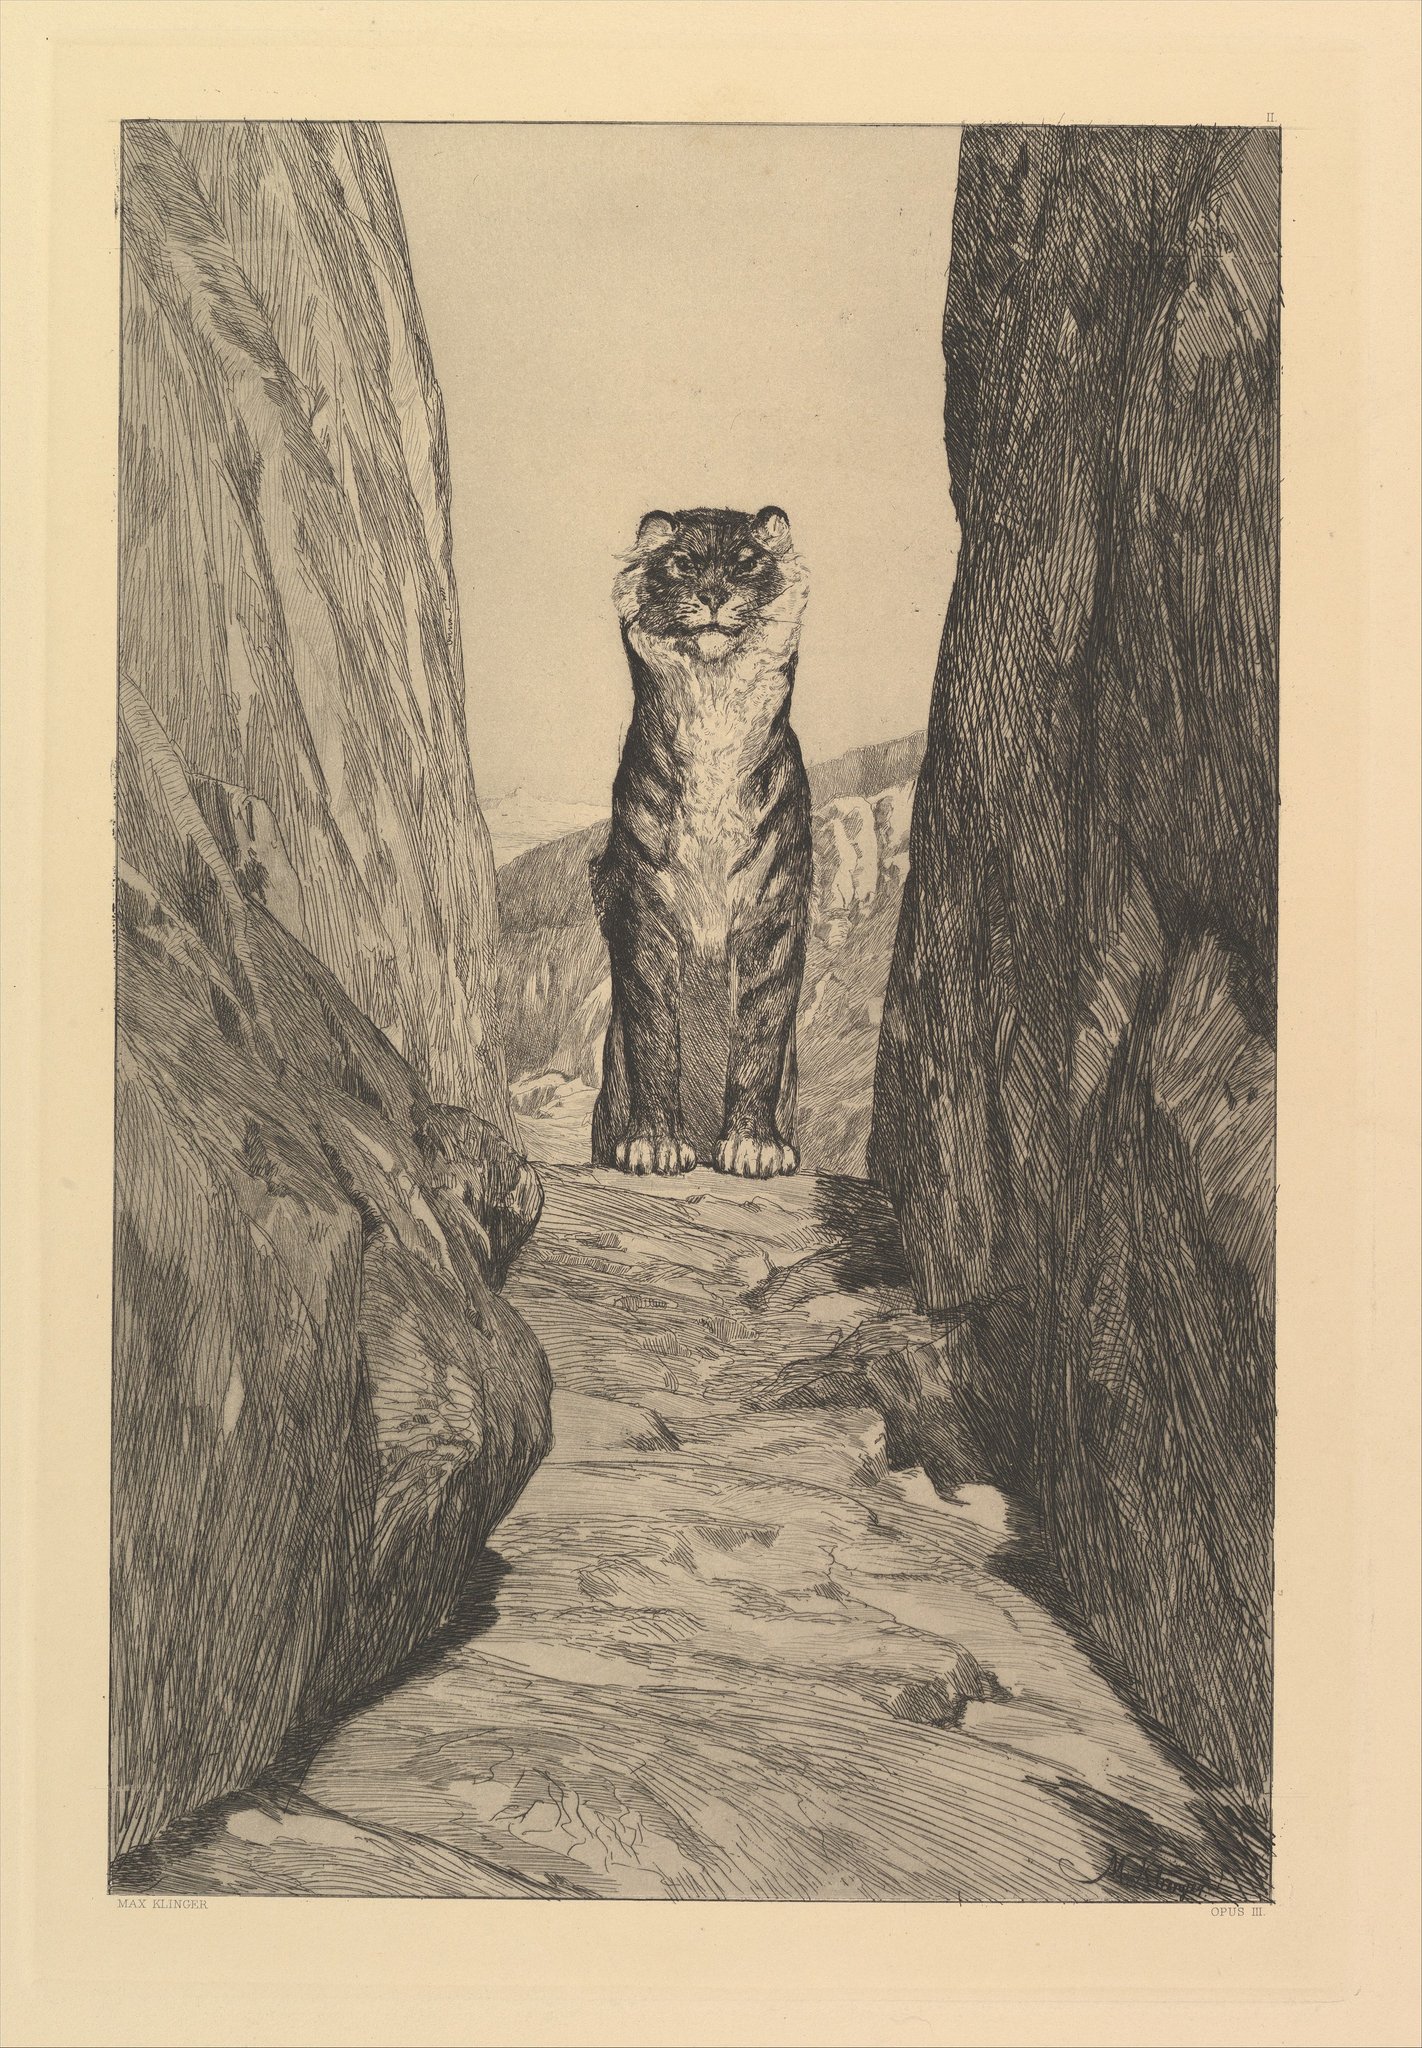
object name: plate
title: Erste Zukunft from Eva und die Zukunft (Rad.-Werk III)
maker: max klinger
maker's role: artist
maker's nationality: german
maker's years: 1857-1920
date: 1898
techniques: aquatint, etching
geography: germany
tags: tigers